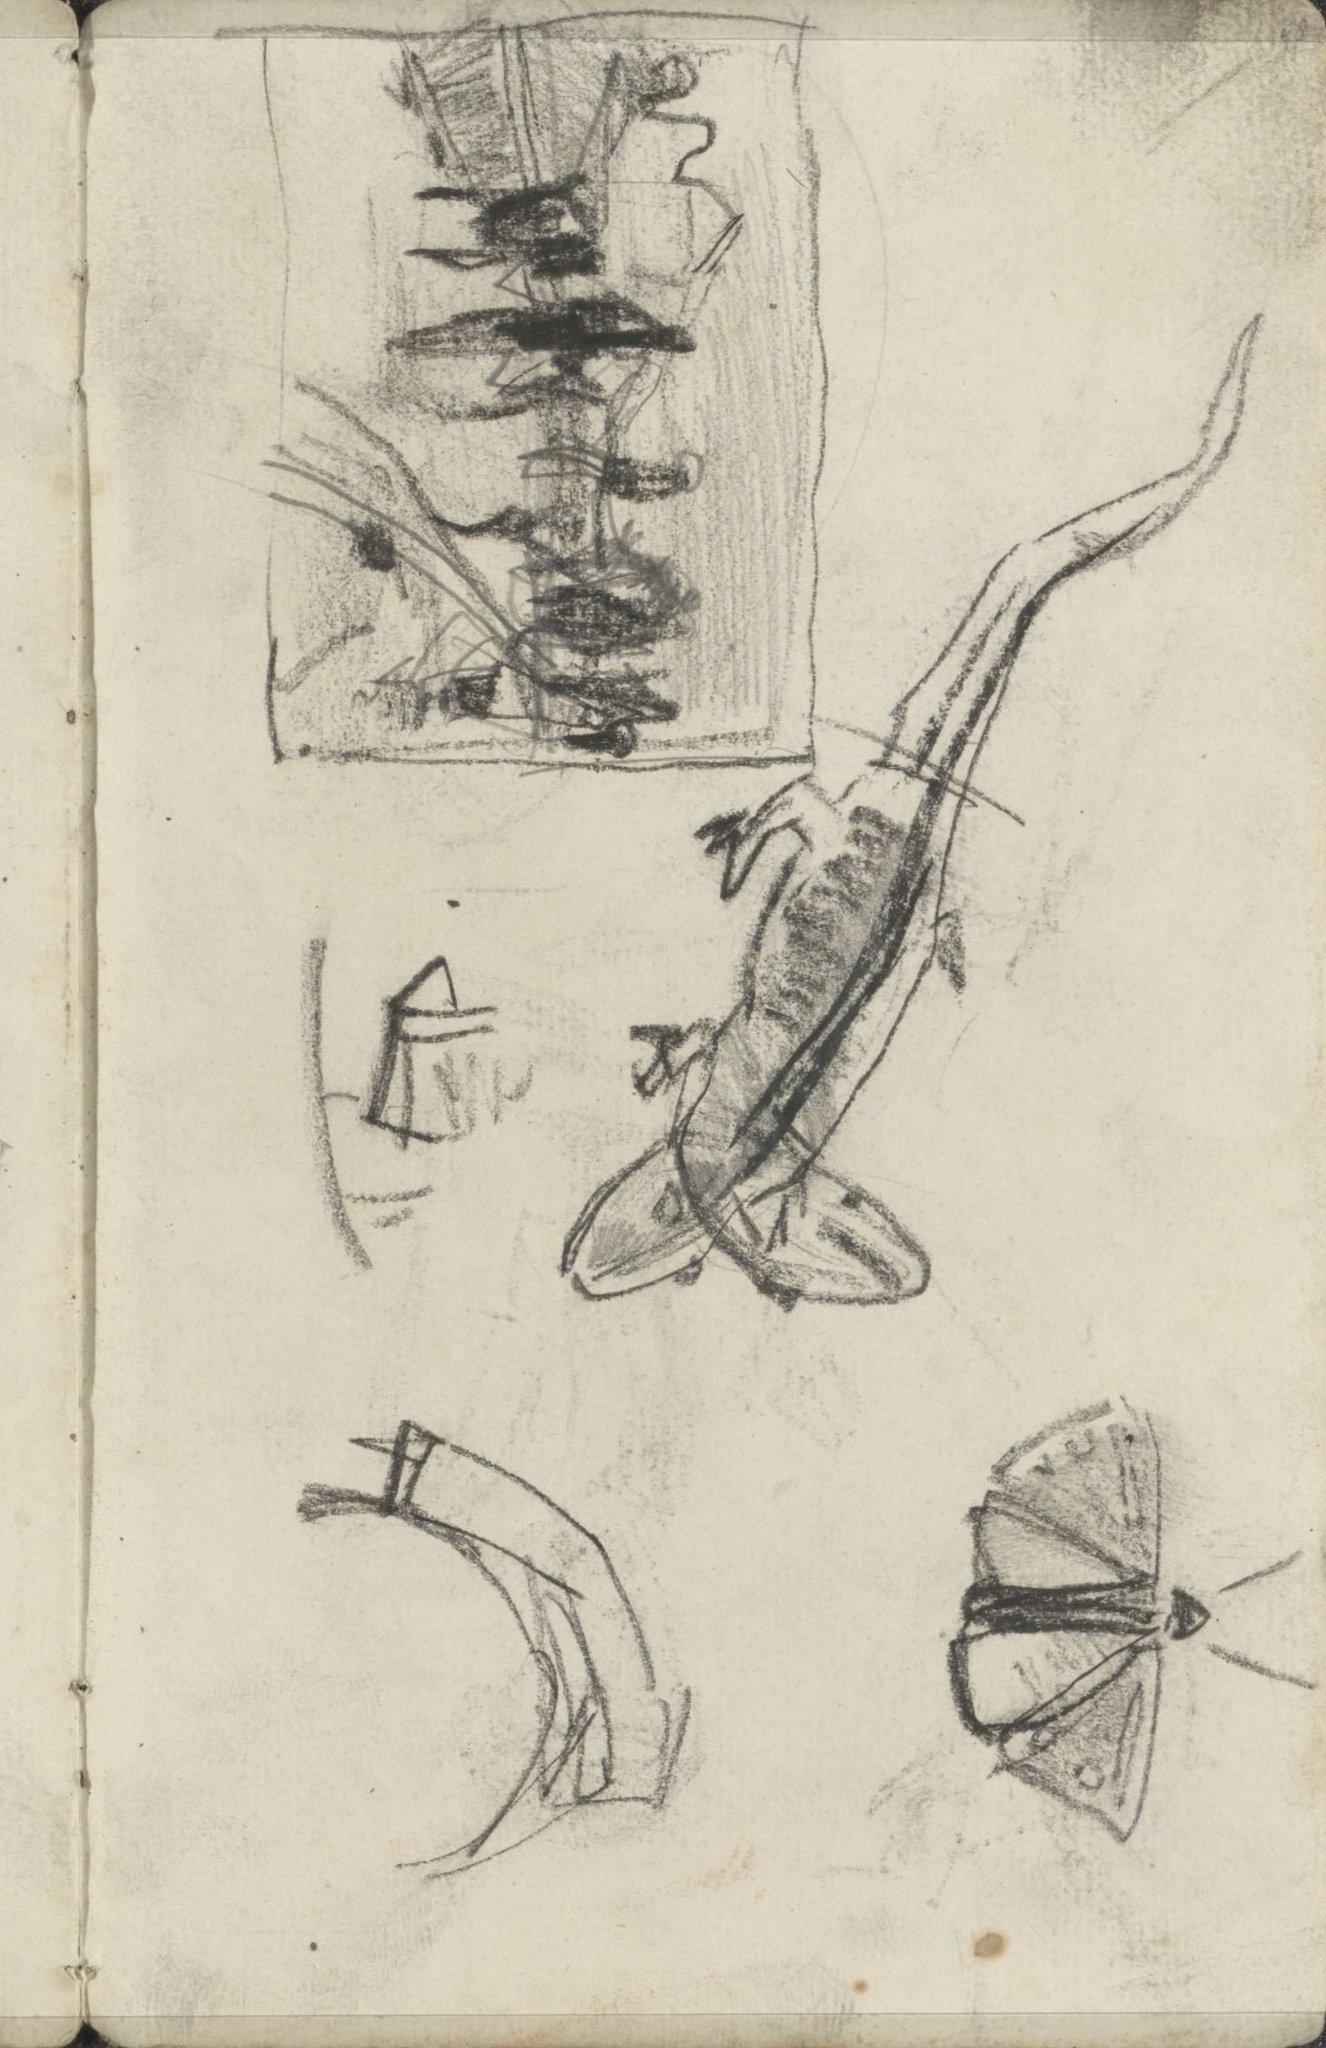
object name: sketchbook leaf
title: Studieblad met ruiters op straat en dieren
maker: george hendrik breitner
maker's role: draughtsman, painter, print maker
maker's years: 1857-1923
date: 1884-1886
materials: chalk, paper, pencil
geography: paris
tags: riding a horse, ass, or mule; rider, horseman, lizards, insects: moth, insects: butterfly, street (+ city(-scape) with figures, staffage)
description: Mogelijk een mot of vlinder en een salamander of hagedis. Pagina 48 uit een schetsboek met 25 bladen.